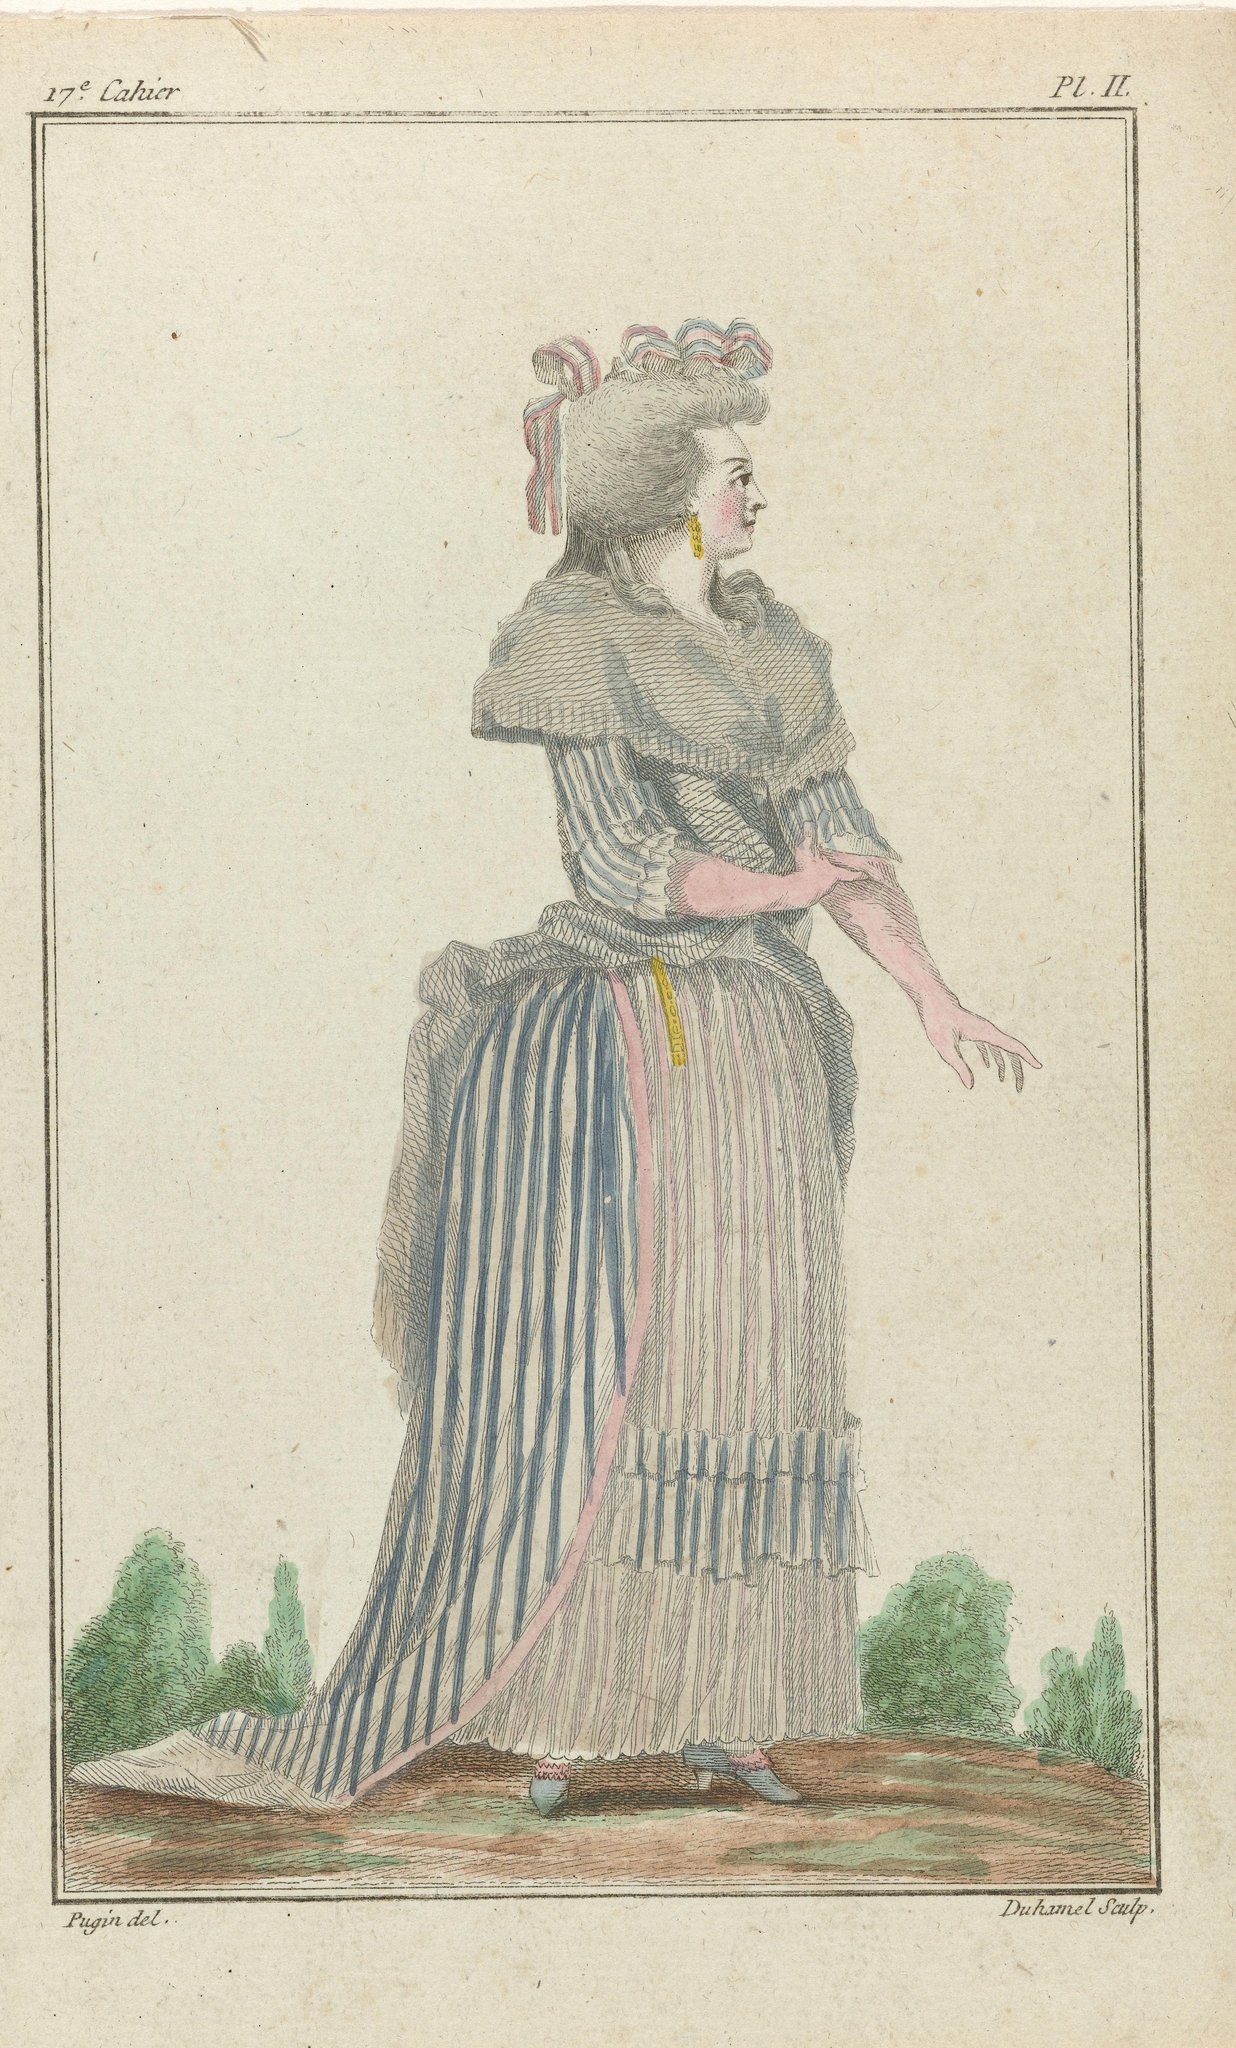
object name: fashion print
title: Cabinet des Modes ou les modes nouvelles, 15 juillet 1786, pl. II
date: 1786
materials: paper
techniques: engraving, hand coloring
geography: paris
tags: ear-rings (+ women's clothes), gloves, mittens (long gloves) (+ women's clothes), clothing for the upper part of the body (shawl) (+ women's clothes), styles of hairdress - aa - ~ women, fashion plates, shoes, sandals (+ women's clothes), skirt (+ women's clothes), dress, gown (+ women's clothes)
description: Robe à la Turque. Volgens de begeleidende tekst is de ‘robe à la Turque’ van witte gaze met wit glanzende en zachtlila strepen, afgezet met zachtroze lint. Sjaal van wit geruite gaze met een franje van witte zijde, van voren gekruist en op de rug onder de ceintuur geknoopt. Kapsel met een gestreept lint. Accessoires: oorbel, lange handschoenen, chatelaine, lila schoenen met hakken en een strook van roze lint. De prent maakt deel uit van het 17e Cahier uit Cabinet des Modes ou les Modes Nouvelles. De serie bestaat uit 72 modeprenten, uitgegeven door Buisson, Parijs, 15 november 1785 - 1 november 1786.